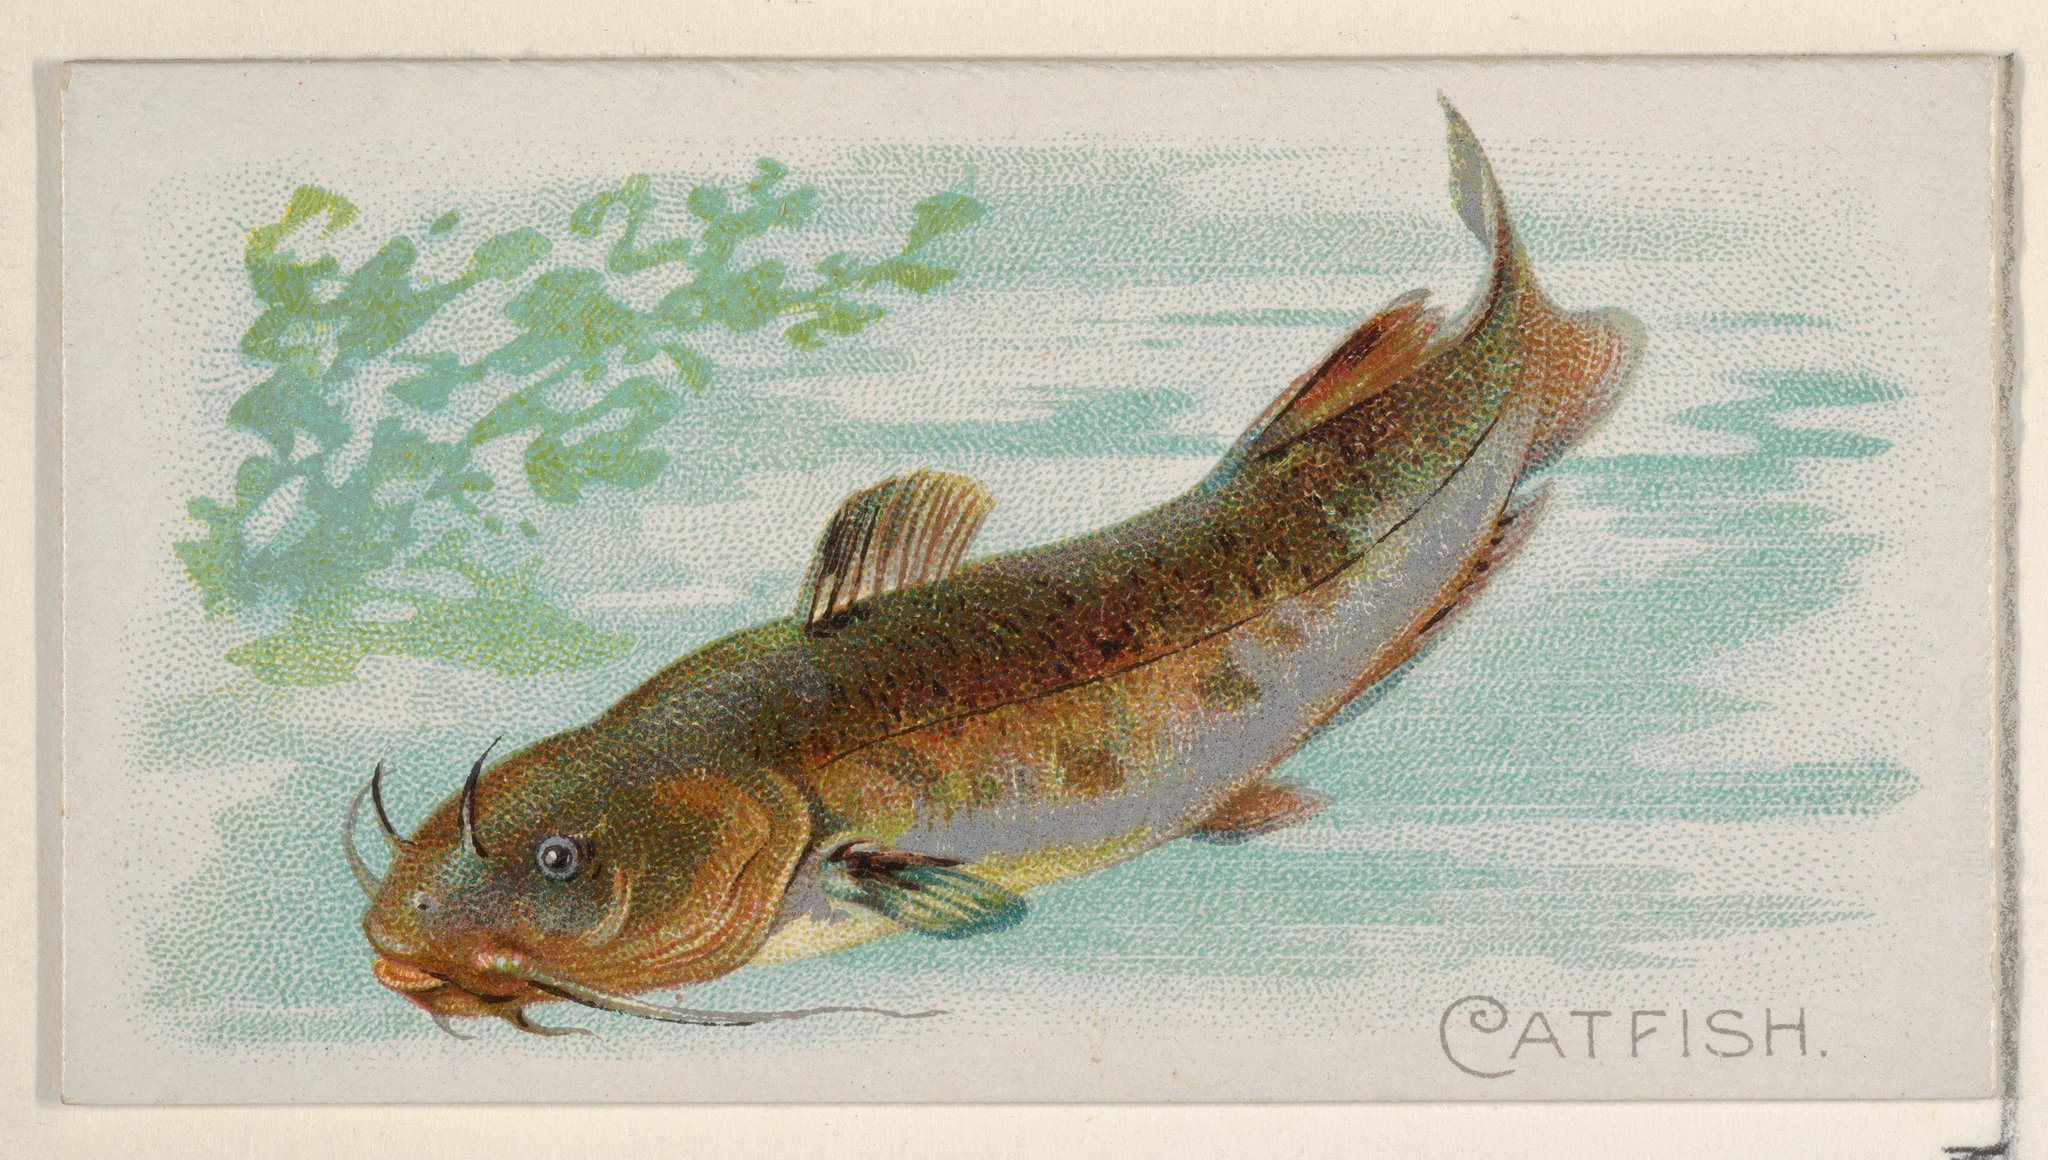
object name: print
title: Catfish, from the Fish from American Waters series (N8) for Allen & Ginter Cigarettes Brands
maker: allen & ginter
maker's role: publisher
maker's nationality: american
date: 1889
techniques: color lithograph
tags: fish